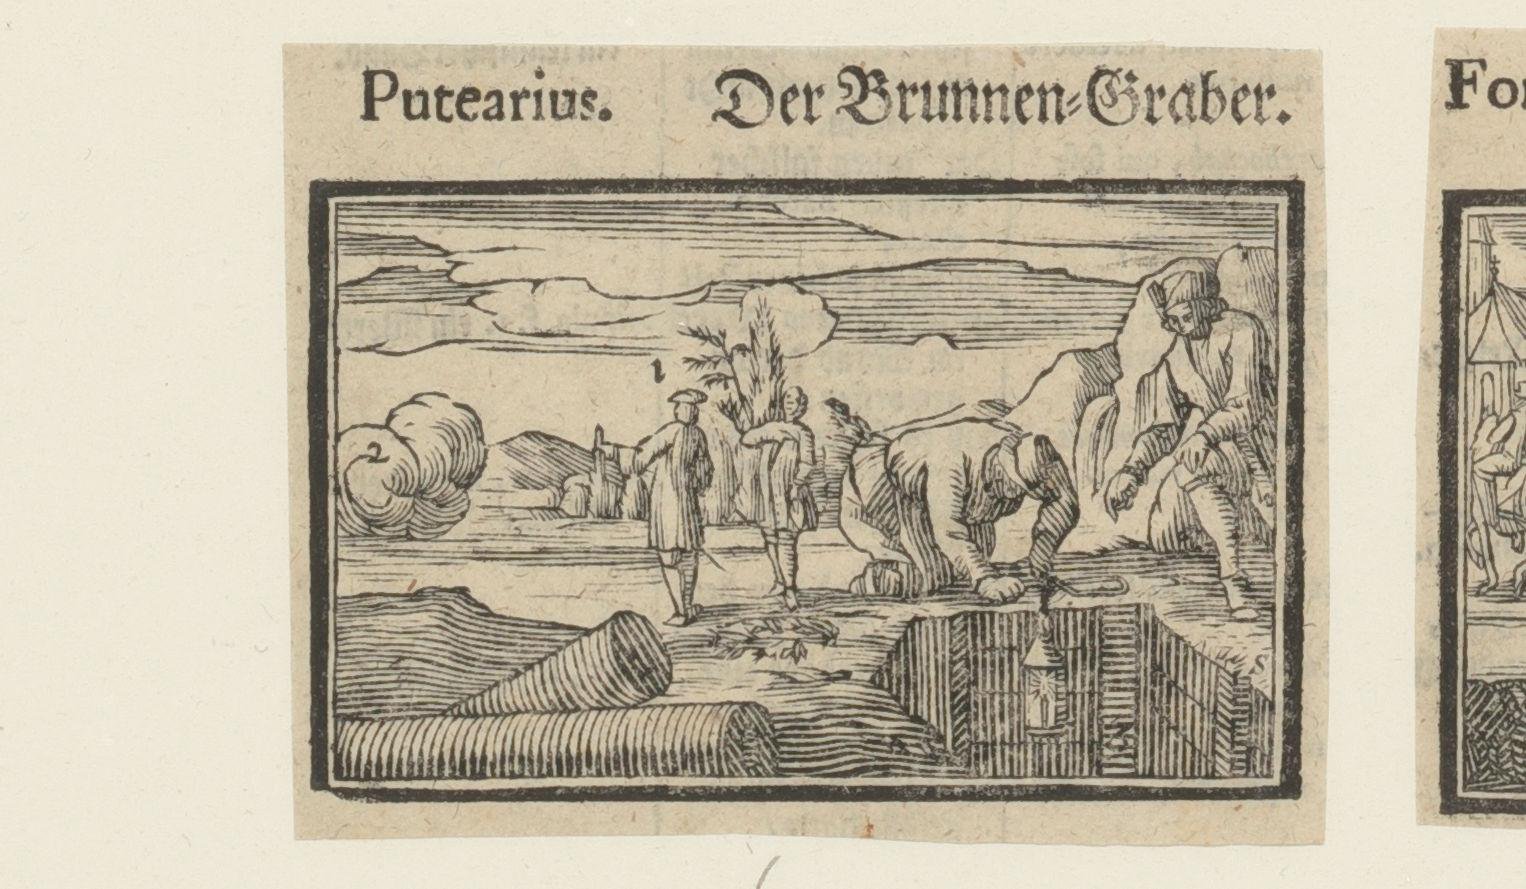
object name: print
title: Puttengraver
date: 1719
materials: paper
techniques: letterpress printing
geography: nuremberg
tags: well, handicrafts, craftsman at work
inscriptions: stamp, collector's mark: Lugt 1641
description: In een landschap kijkt de puttengraver naar een damp die uit de grond opstijgt. Hieruit kan blijken dat ter plekke een bron is. Op de voorgrond laat een man een lantaarn in een put zakken om de zuiverheid van de lucht te controleren. Onderwerpsrubrieken binnen de Atlas Zeden en Gewoonten: Handel, Nijverheid en Verkeer, Beroep en bedrijf, Complete suites.